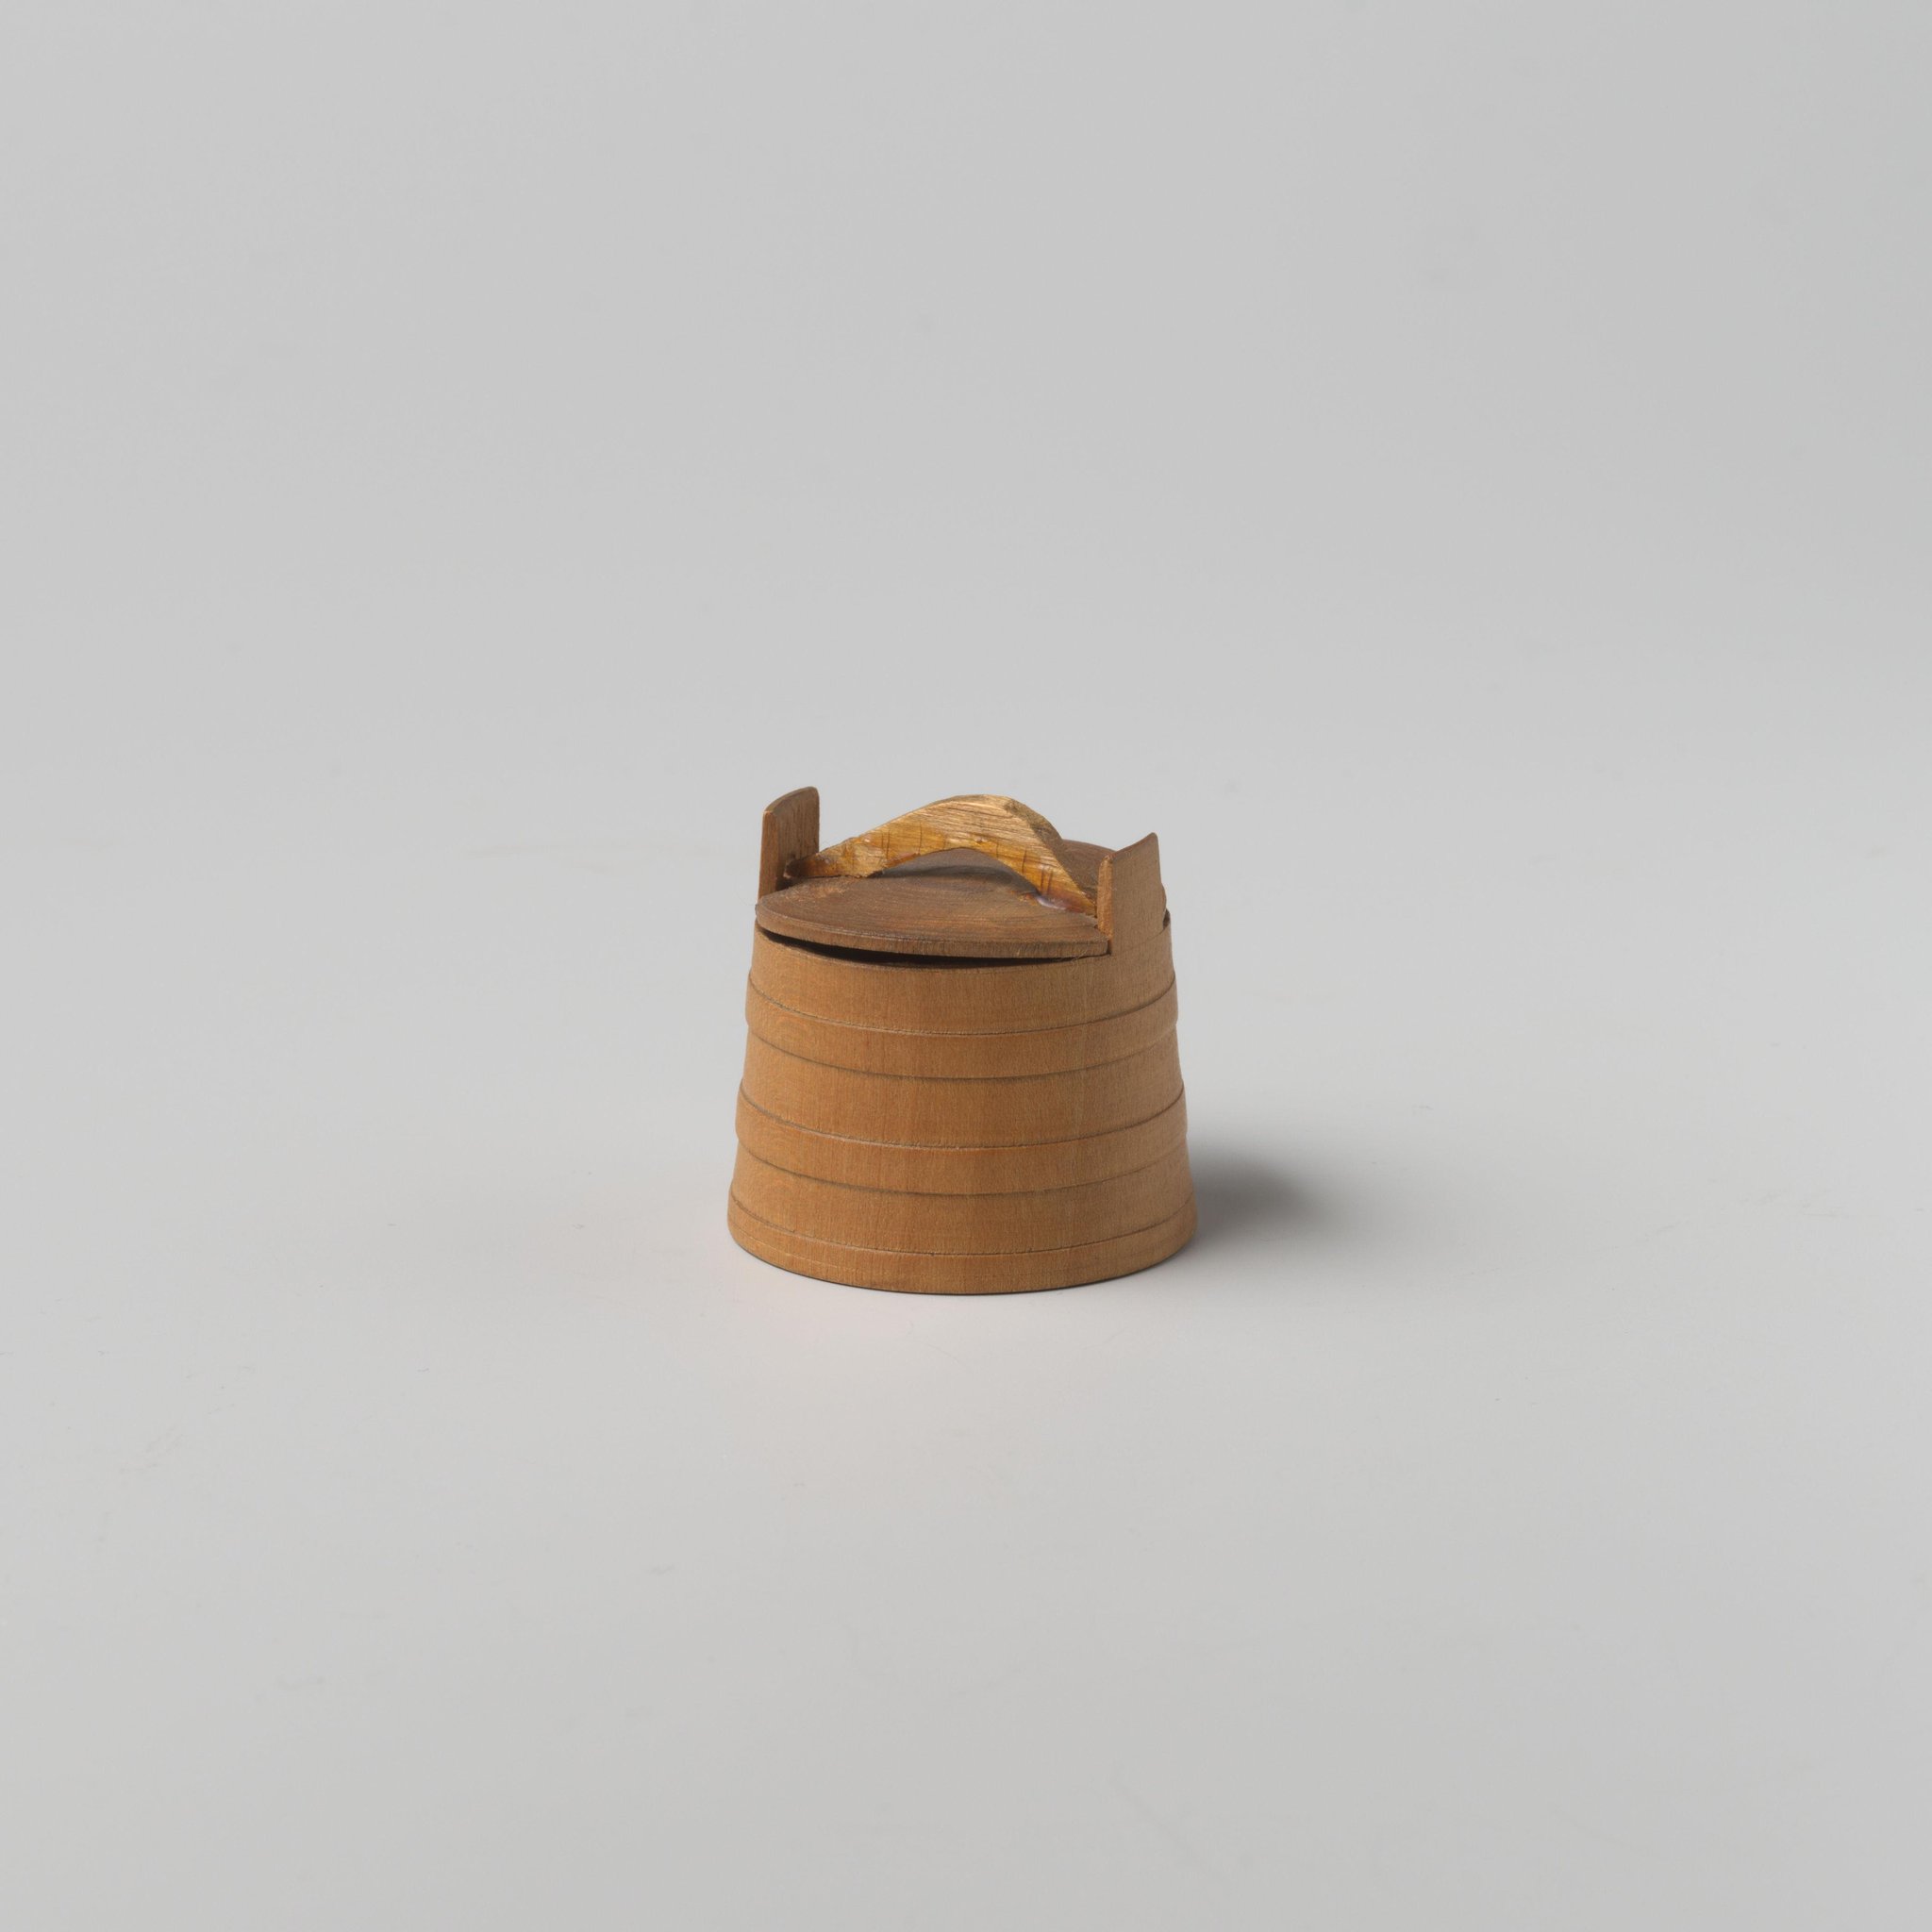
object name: vat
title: Kuip of vat van esdoornhout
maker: Anonymous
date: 1676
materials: wood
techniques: turning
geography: amsterdam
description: Kuip of vat, gedraaid van esdoornhout, met ringen (hoepels voorstellende). De kuip versmalt zich naar boven toe. Op de rand twee rechtopstaande uitsteeksels, waartussen een deksel past met opgezette asymmetrische handgreep.